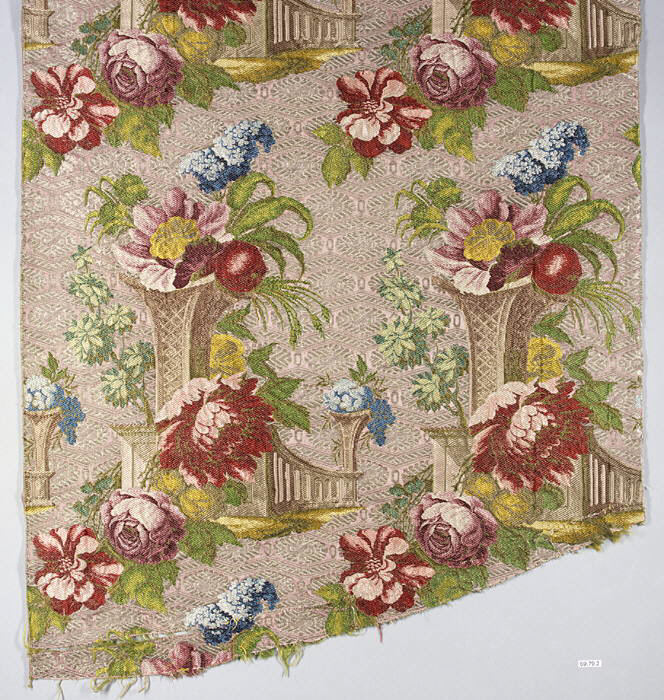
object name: length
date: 1701-1750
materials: silk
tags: flowers,leaves